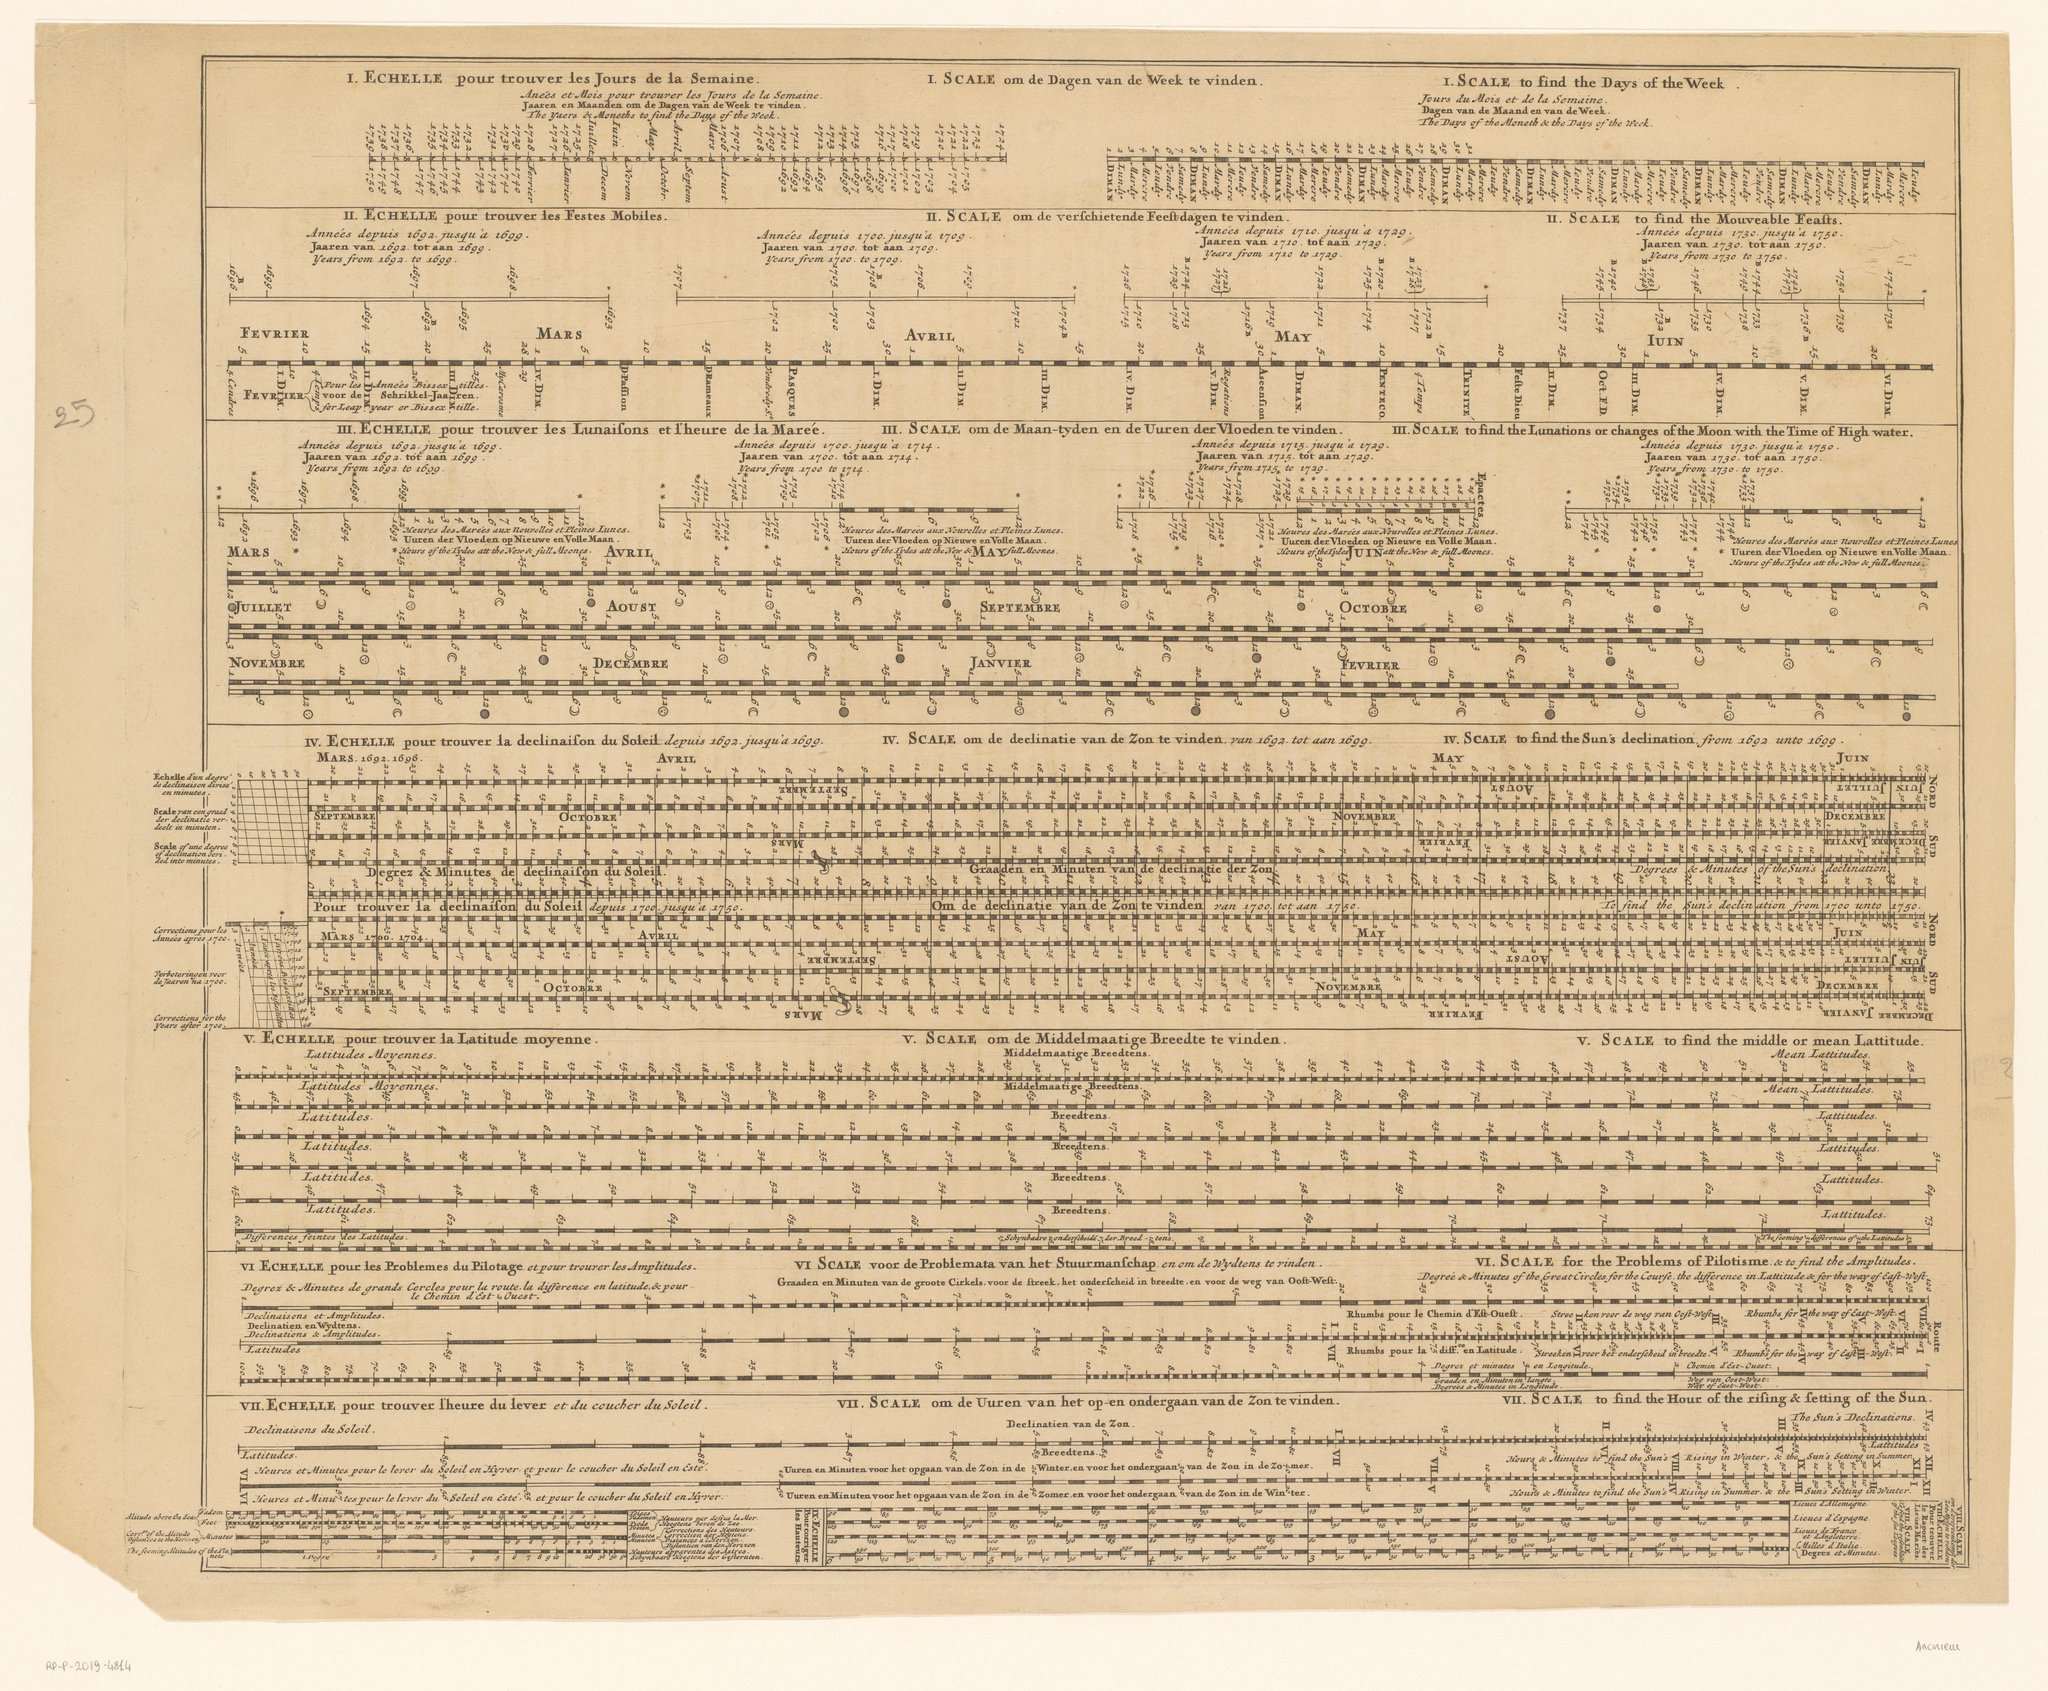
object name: print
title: Negen schalen met verschillende metingen en dagen in het jaar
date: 1692-1695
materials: paper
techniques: engraving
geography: amsterdam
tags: scales of notation (arithmetic)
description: Prent vermoedelijk gebruikt in een editie van: Le Neptune François, Ou Atlas Nouveau des Cartes Marines. Amsterdam: Pieter Mortier (I), 1693-1695. Of mogelijk gebruikt in latere editie van deze atlas.